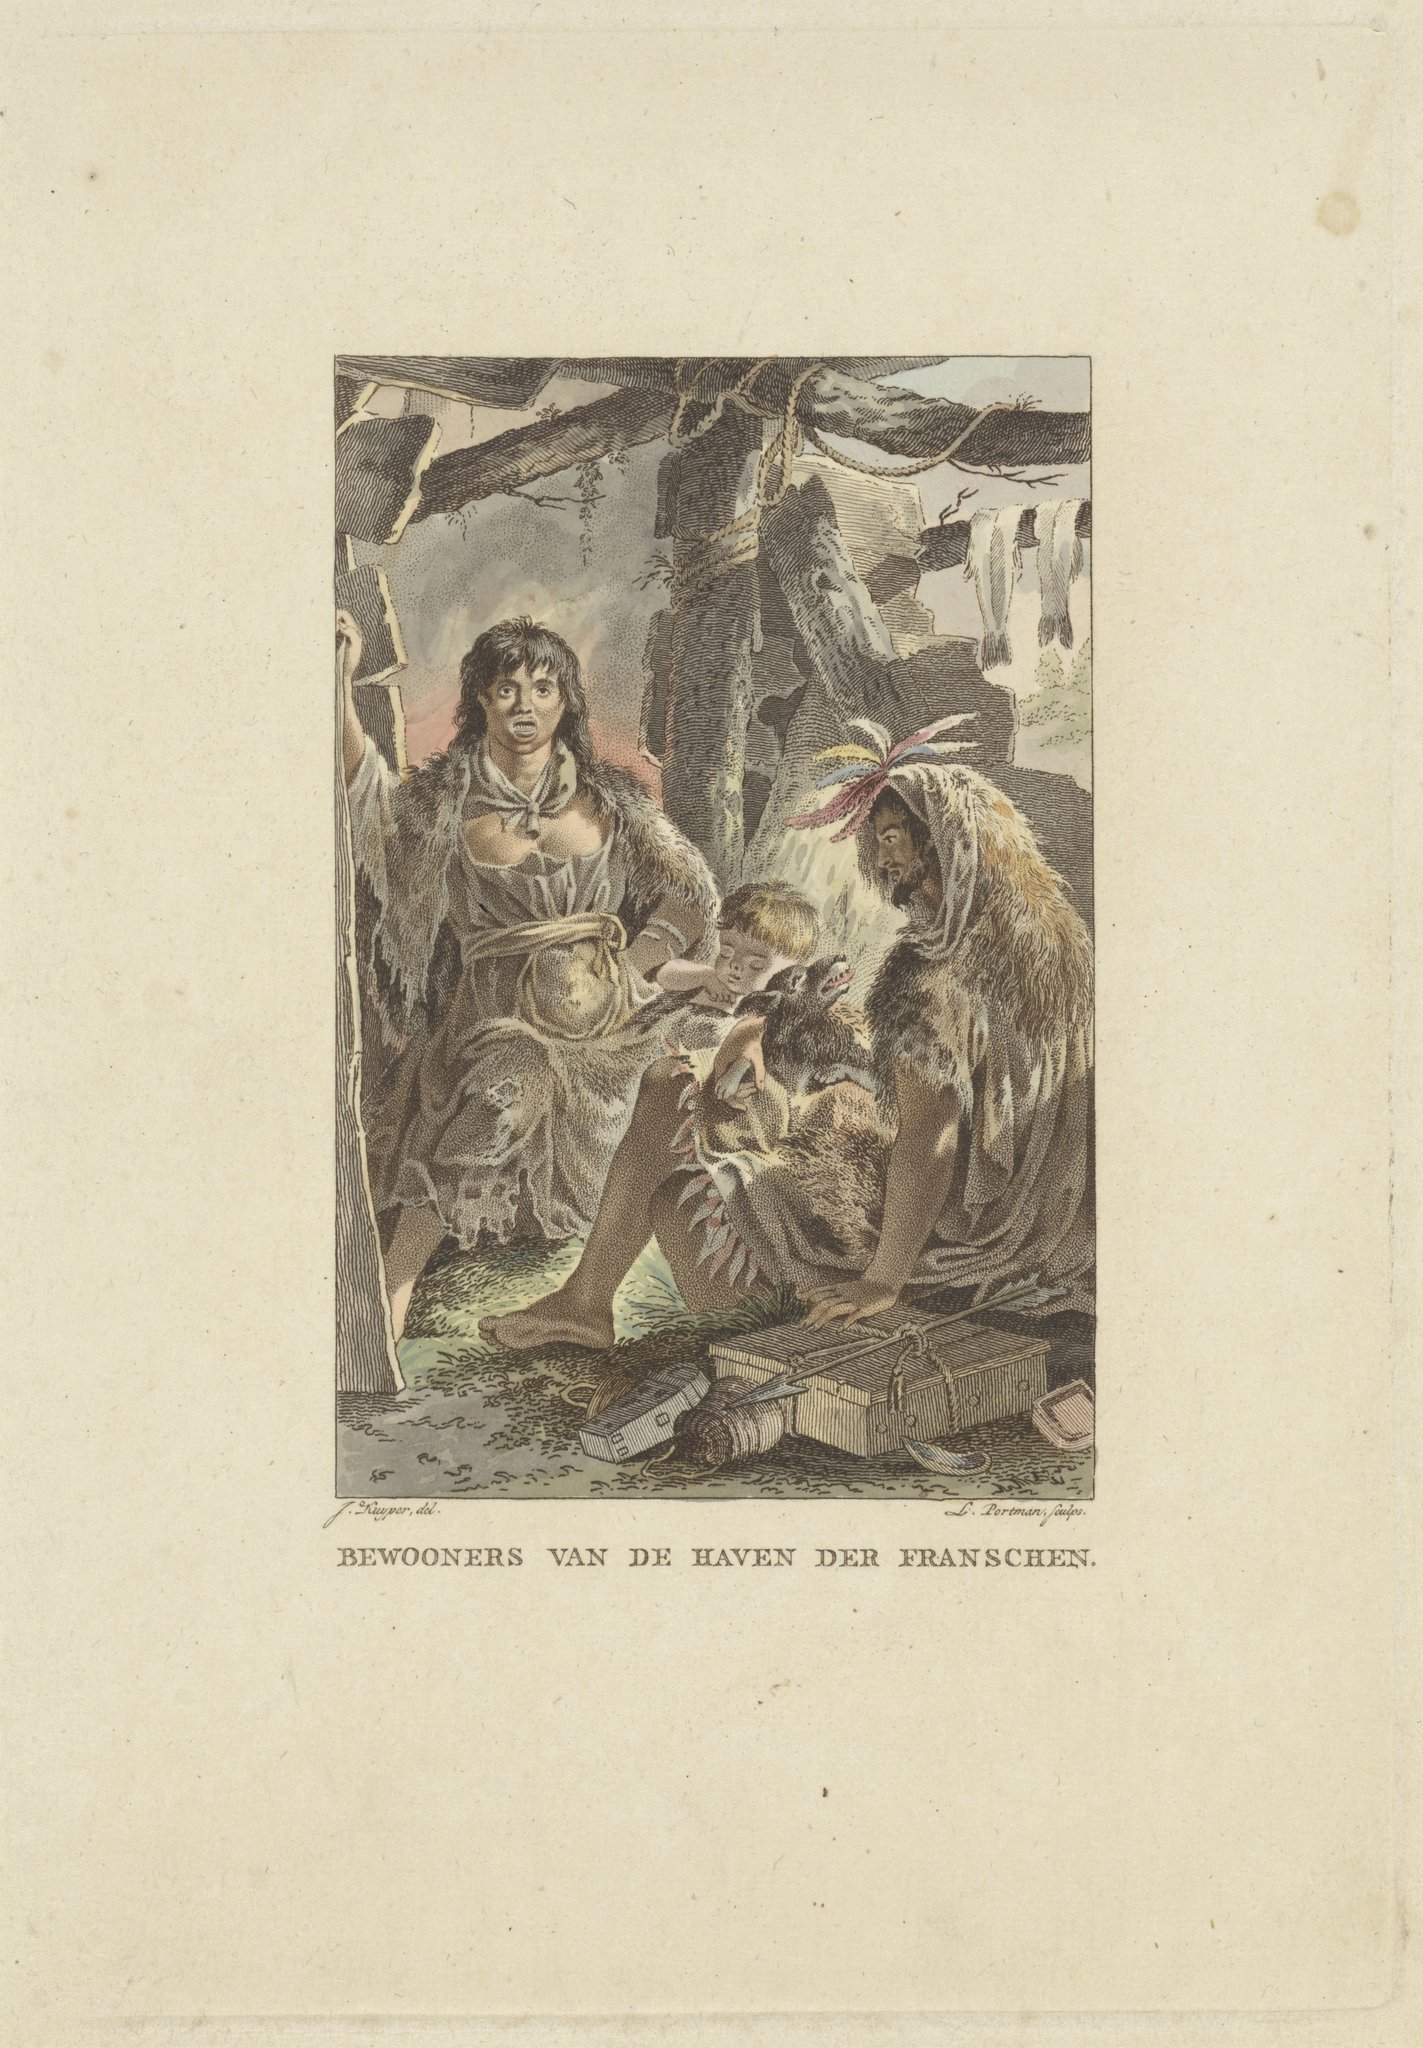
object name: print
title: Gezin in hun hut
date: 1804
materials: paper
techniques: etching, hand coloring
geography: amsterdam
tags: human races; peoples; nationalities (+ costume)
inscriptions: collector's mark: Lugt 2228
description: Man en vrouw zitten met hun kind te midden van hun huisraad. Bijzonder is dat de man opmerkelijk lange nagels heeft. Ze dragen traditionele kleding.